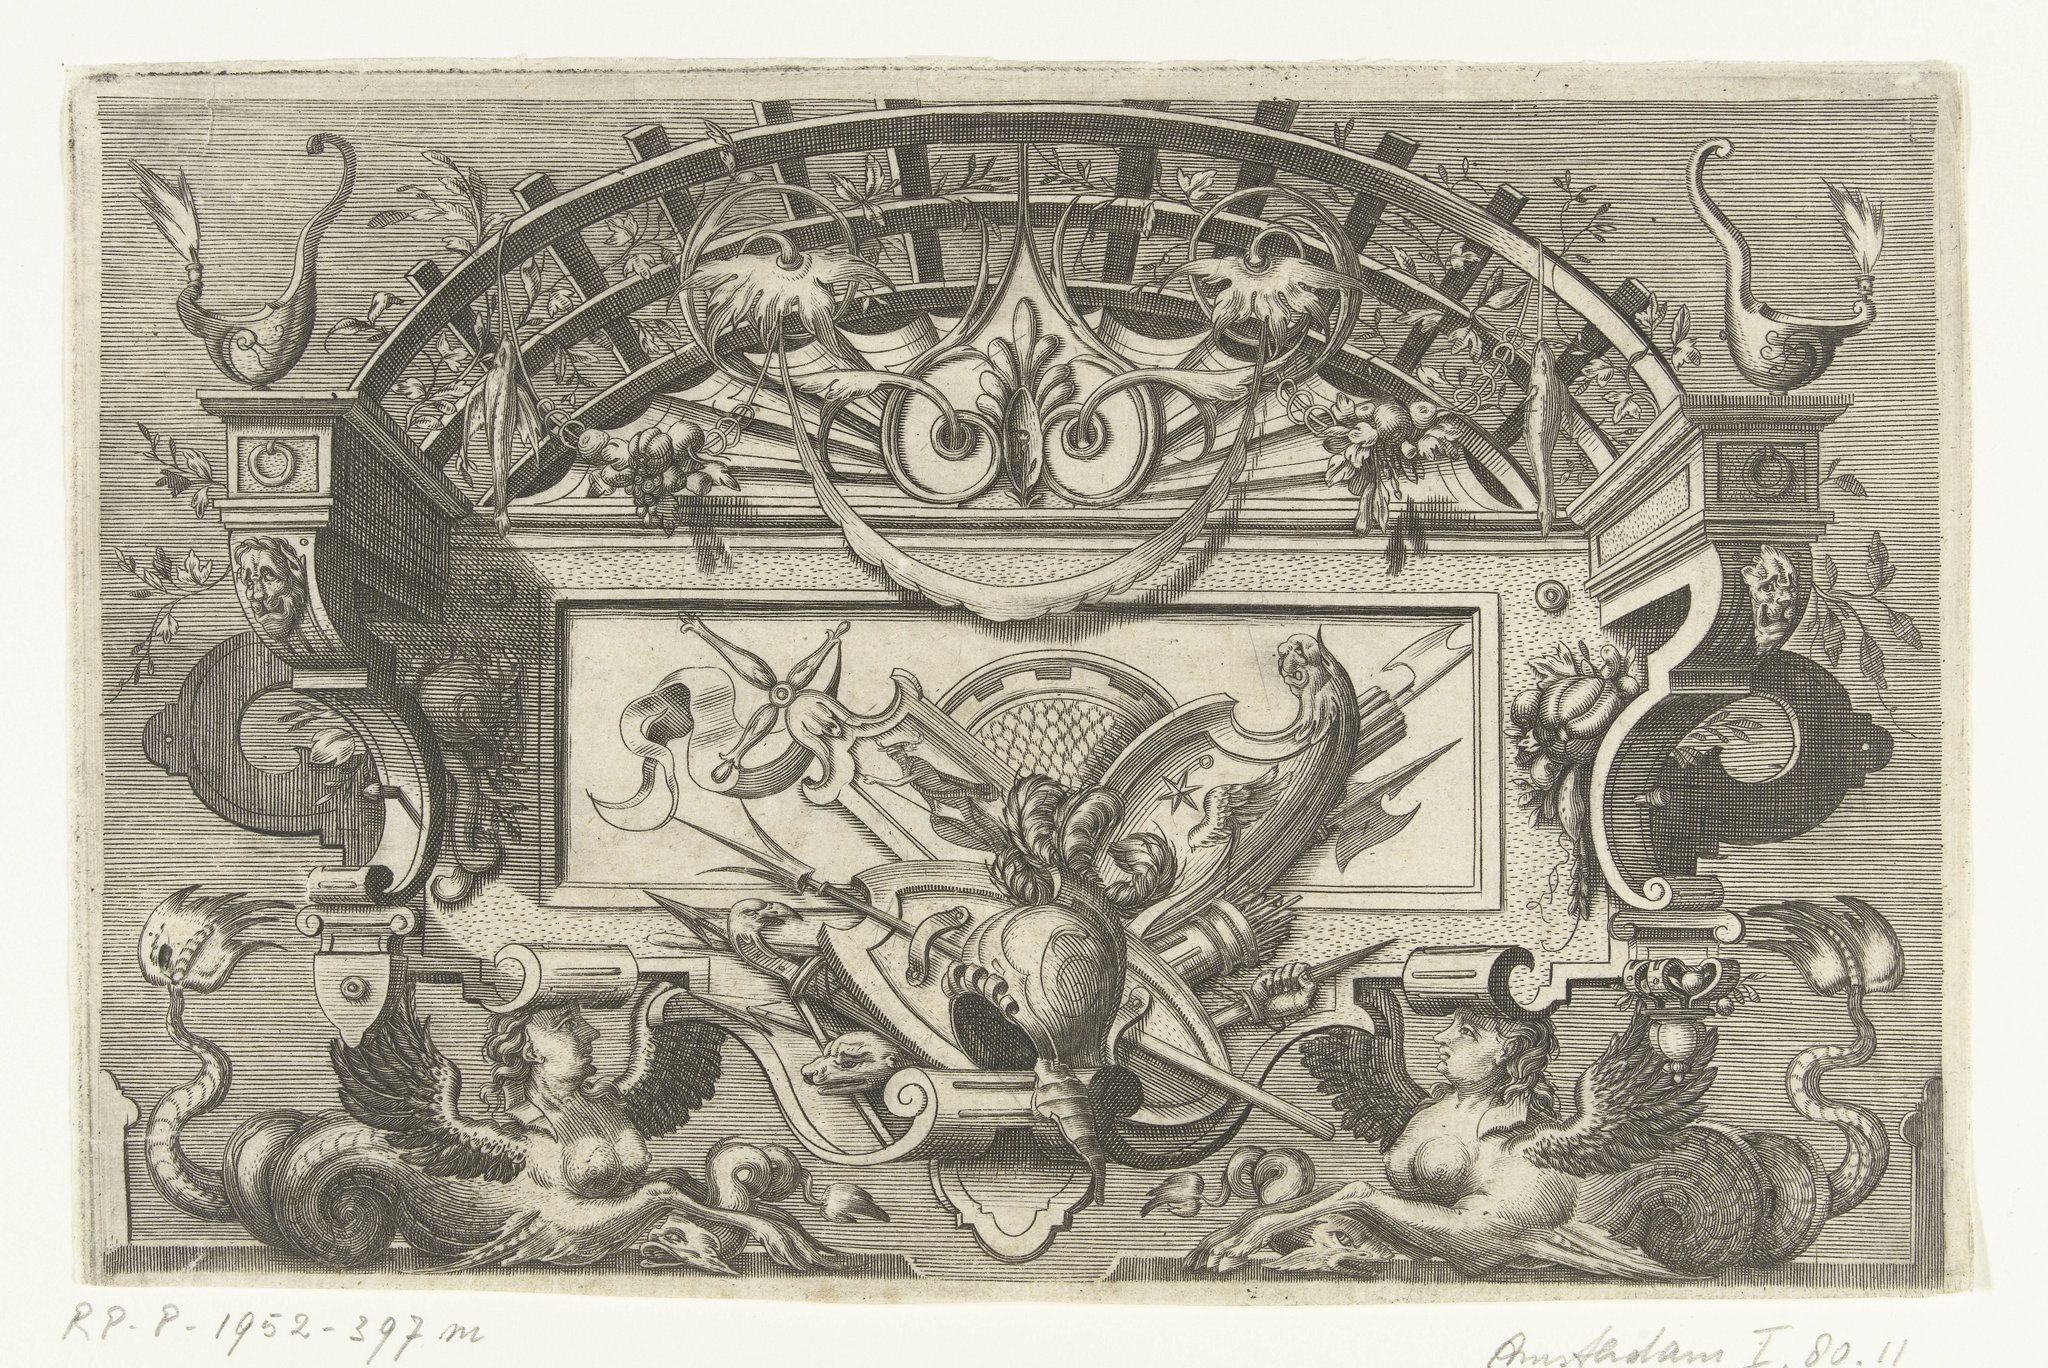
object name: print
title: Cartouche in een omlijsting van rolwerk, met een wapentrofee en twee sfinxen met vissenstaarten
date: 1564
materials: paper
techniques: engraving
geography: antwerp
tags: sphinx (lion/woman); 'sfinge' (ripa) - aa - female human figure, fabulous animals (sometimes wrongly called 'grotesques'); 'mostri' (ripa), 'tropaion', i.e. decorative ornament ~ weapons, fishes, pergola, oil-lamp, ornament ~ cartouche, ornament ~ festoon, garland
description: Cartouche in een omlijsting van rolwerk. Bovenaan een pergola rustend op twee consoles. Links- en rechtsboven een olielamp. Onderaan een wapentrofee. De cartouche rust op de hoofden van twee sfinxen met vissenstaarten, die ieder een vis tussen de voorpoten hebben.